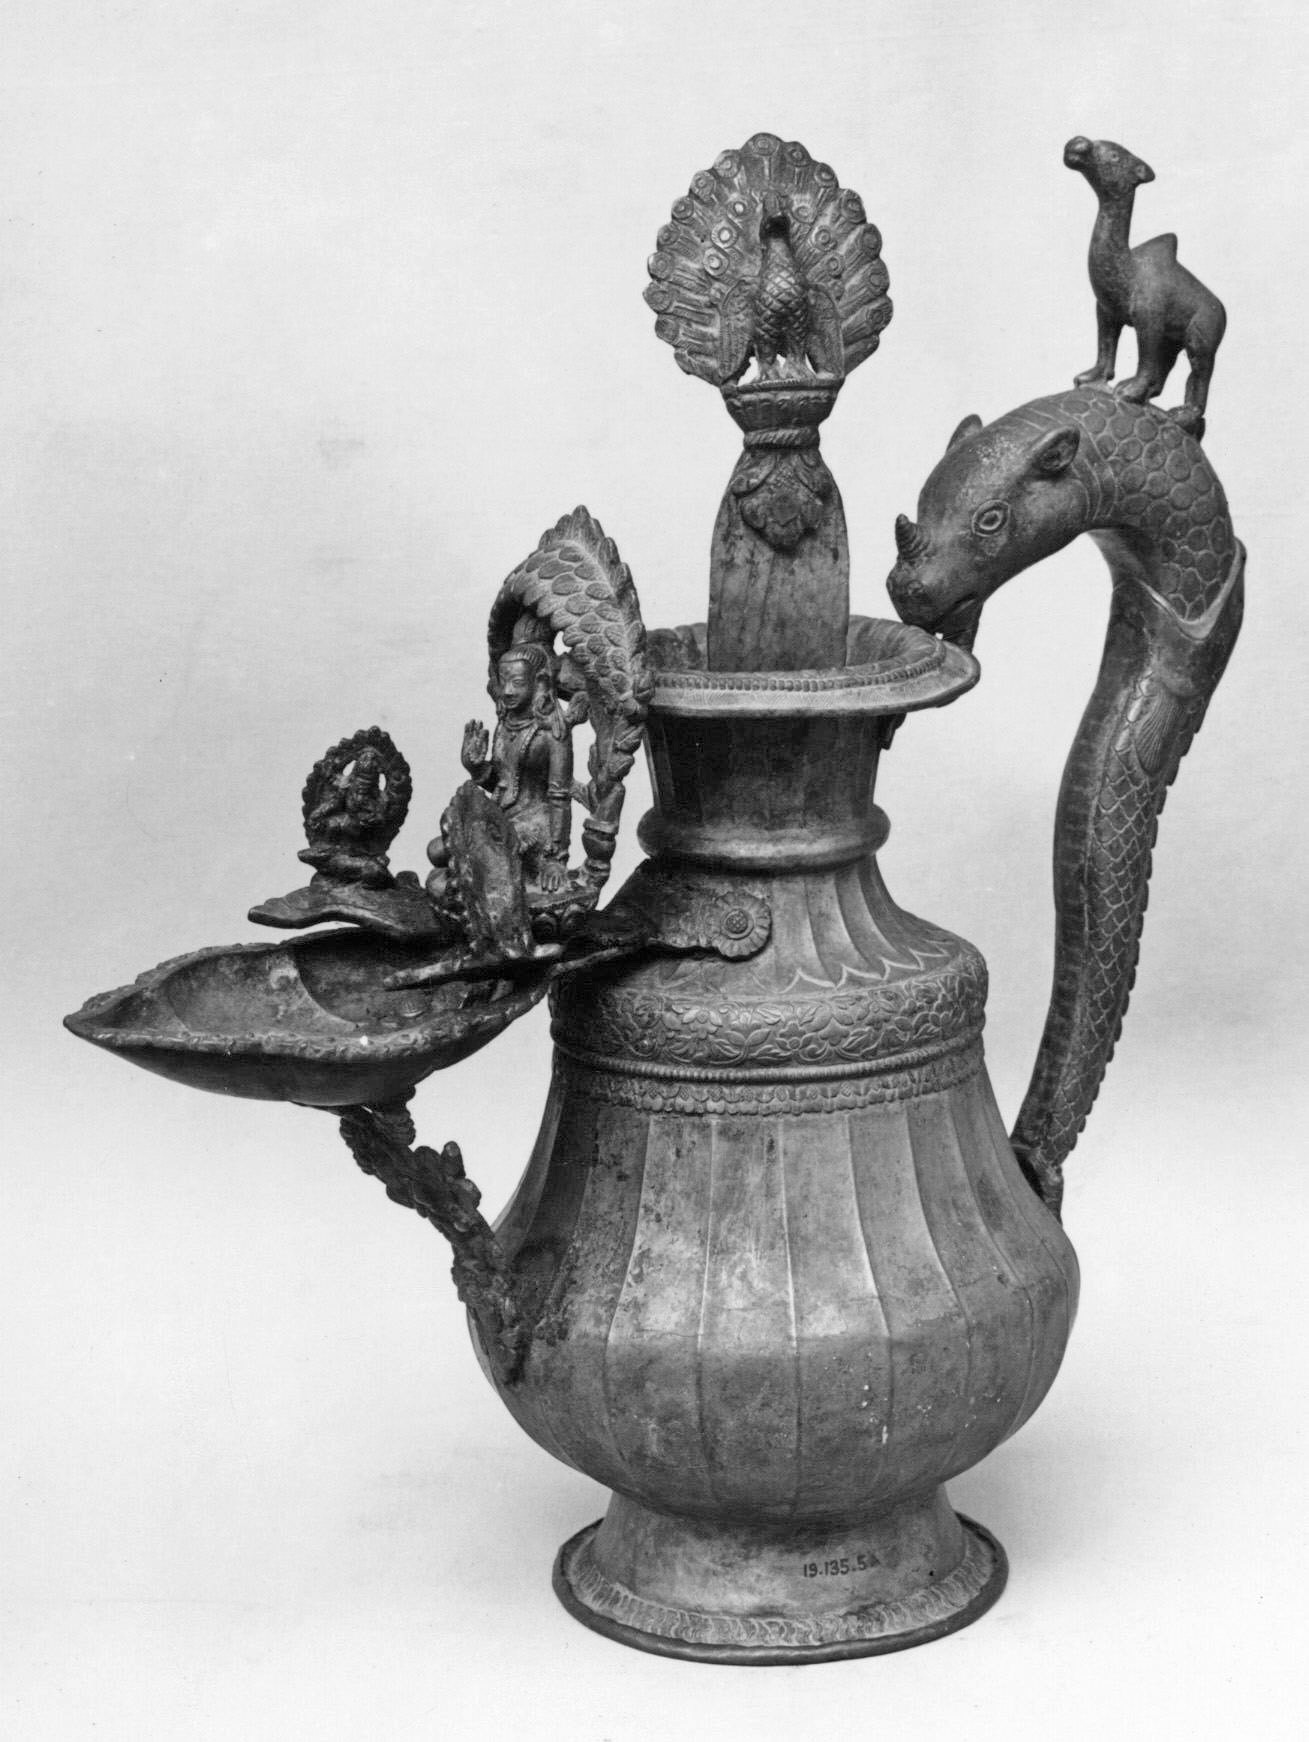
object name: vase or lamp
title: Sacrificial Vase or Lamp with Ladle (Arti)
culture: nepali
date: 1701-1800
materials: brass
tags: peacocks,camels